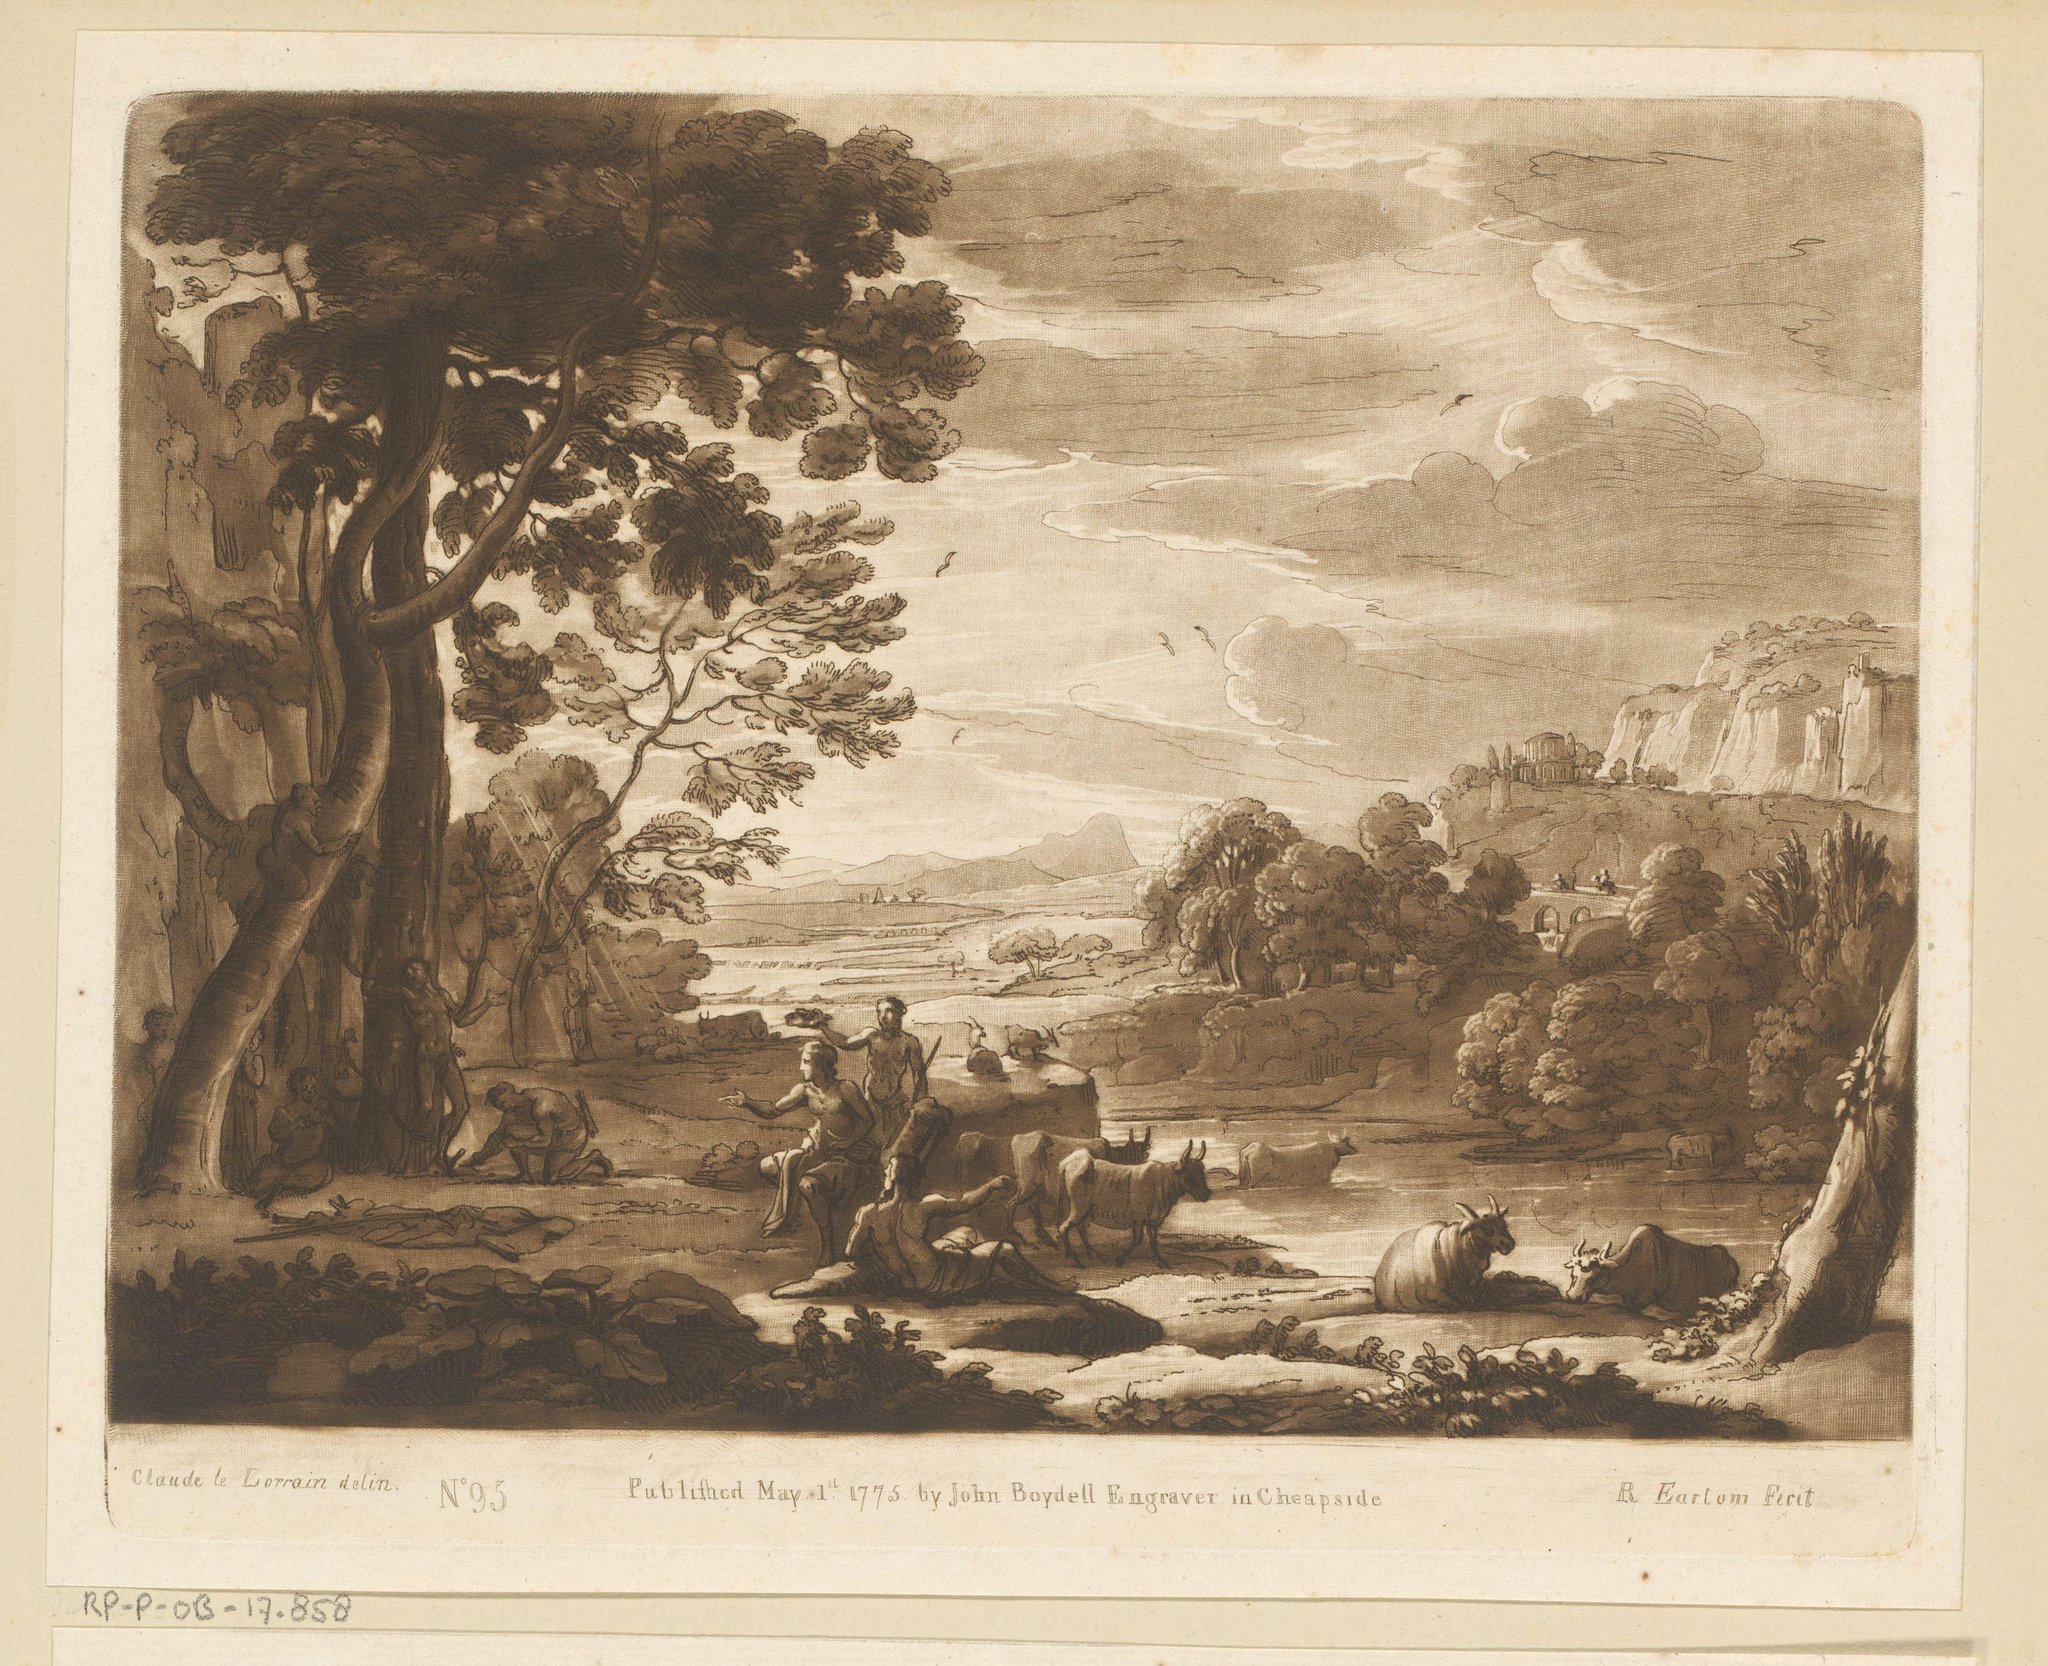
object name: print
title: Prenten naar tekeningen van Claude Lorrain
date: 1775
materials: paper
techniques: etching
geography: london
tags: cattle, punishment of marsyas: he is flayed by apollo, (high) hill - hh - ideal landscapes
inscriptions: date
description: Vanaf 1774 publiceerde John Boydell tweehonderd prenten naar het tekeningenboek Liber Veritatis van Claude Lorrain, in het bezit van de hertogen van Cavendish. Deze prenten werden vanaf 1777 in twee volumes gebundeld uitgegeven.